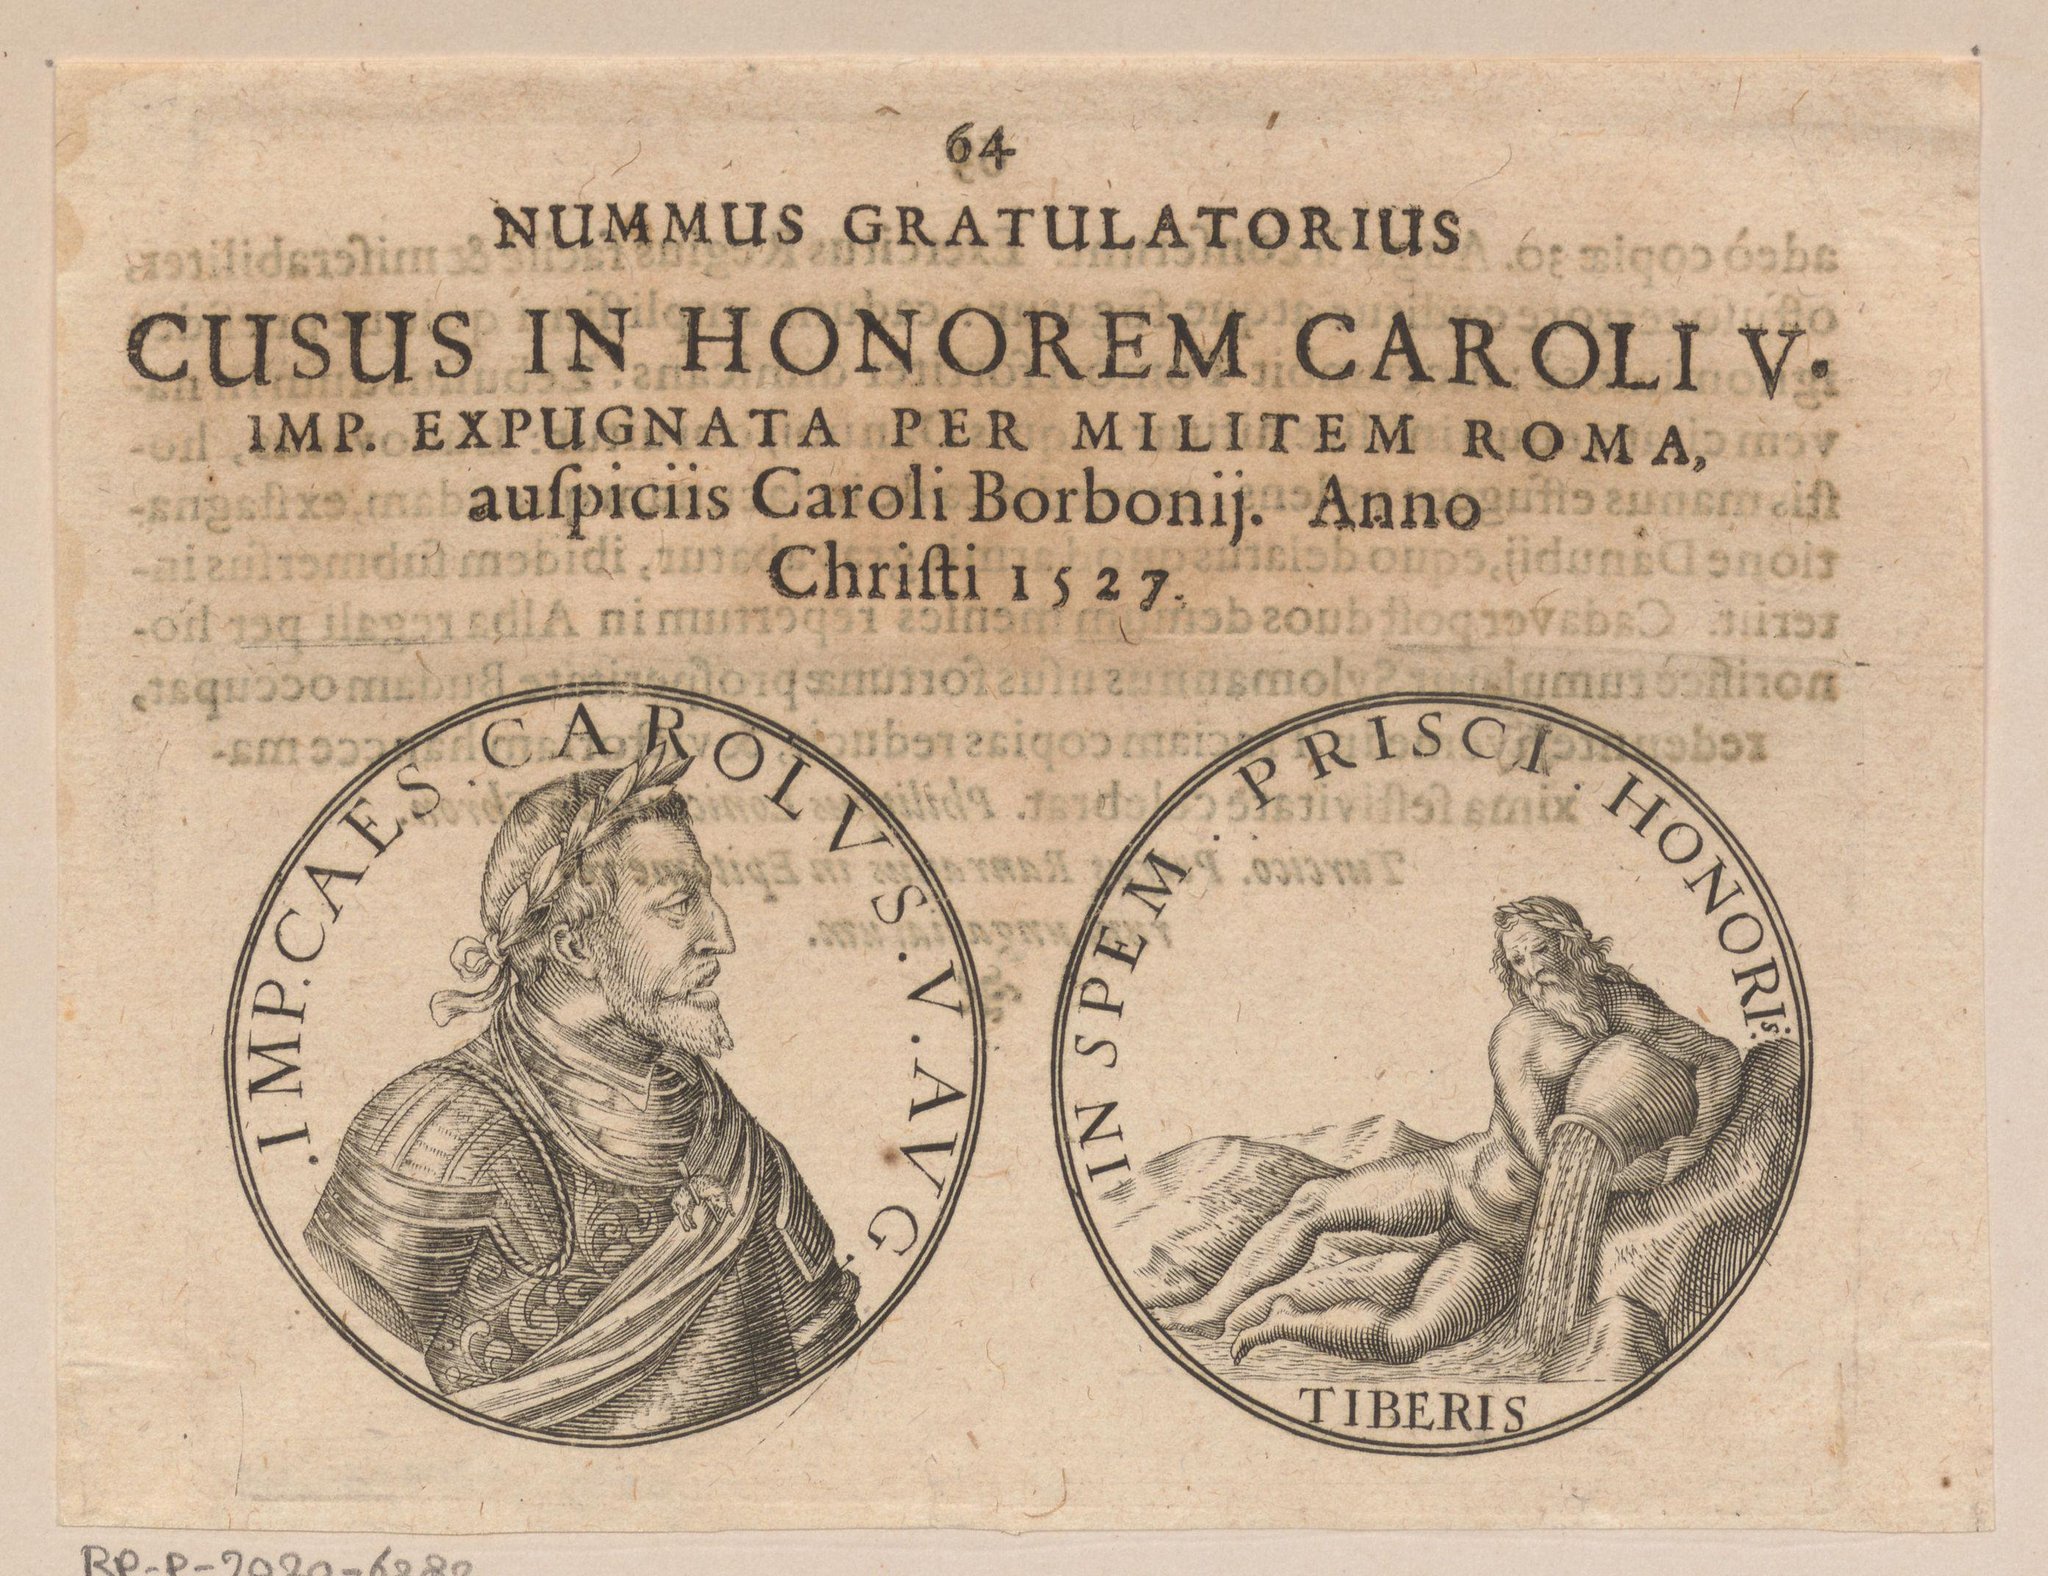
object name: book illustration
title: Medaille met het portret van keizer Karel V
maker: Anonymous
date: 1620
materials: paper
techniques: engraving, letterpress printing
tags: ghent, charles v (holy roman emperor and king of spain), historical persons, knighthood order of the golden fleece, river-gods, king, dog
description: Prent uit: Lucke, Johann Jacob. Sylloge numismatum elegantiorum quae diuersi (...). S.l.s.n.,1620, p. 64.